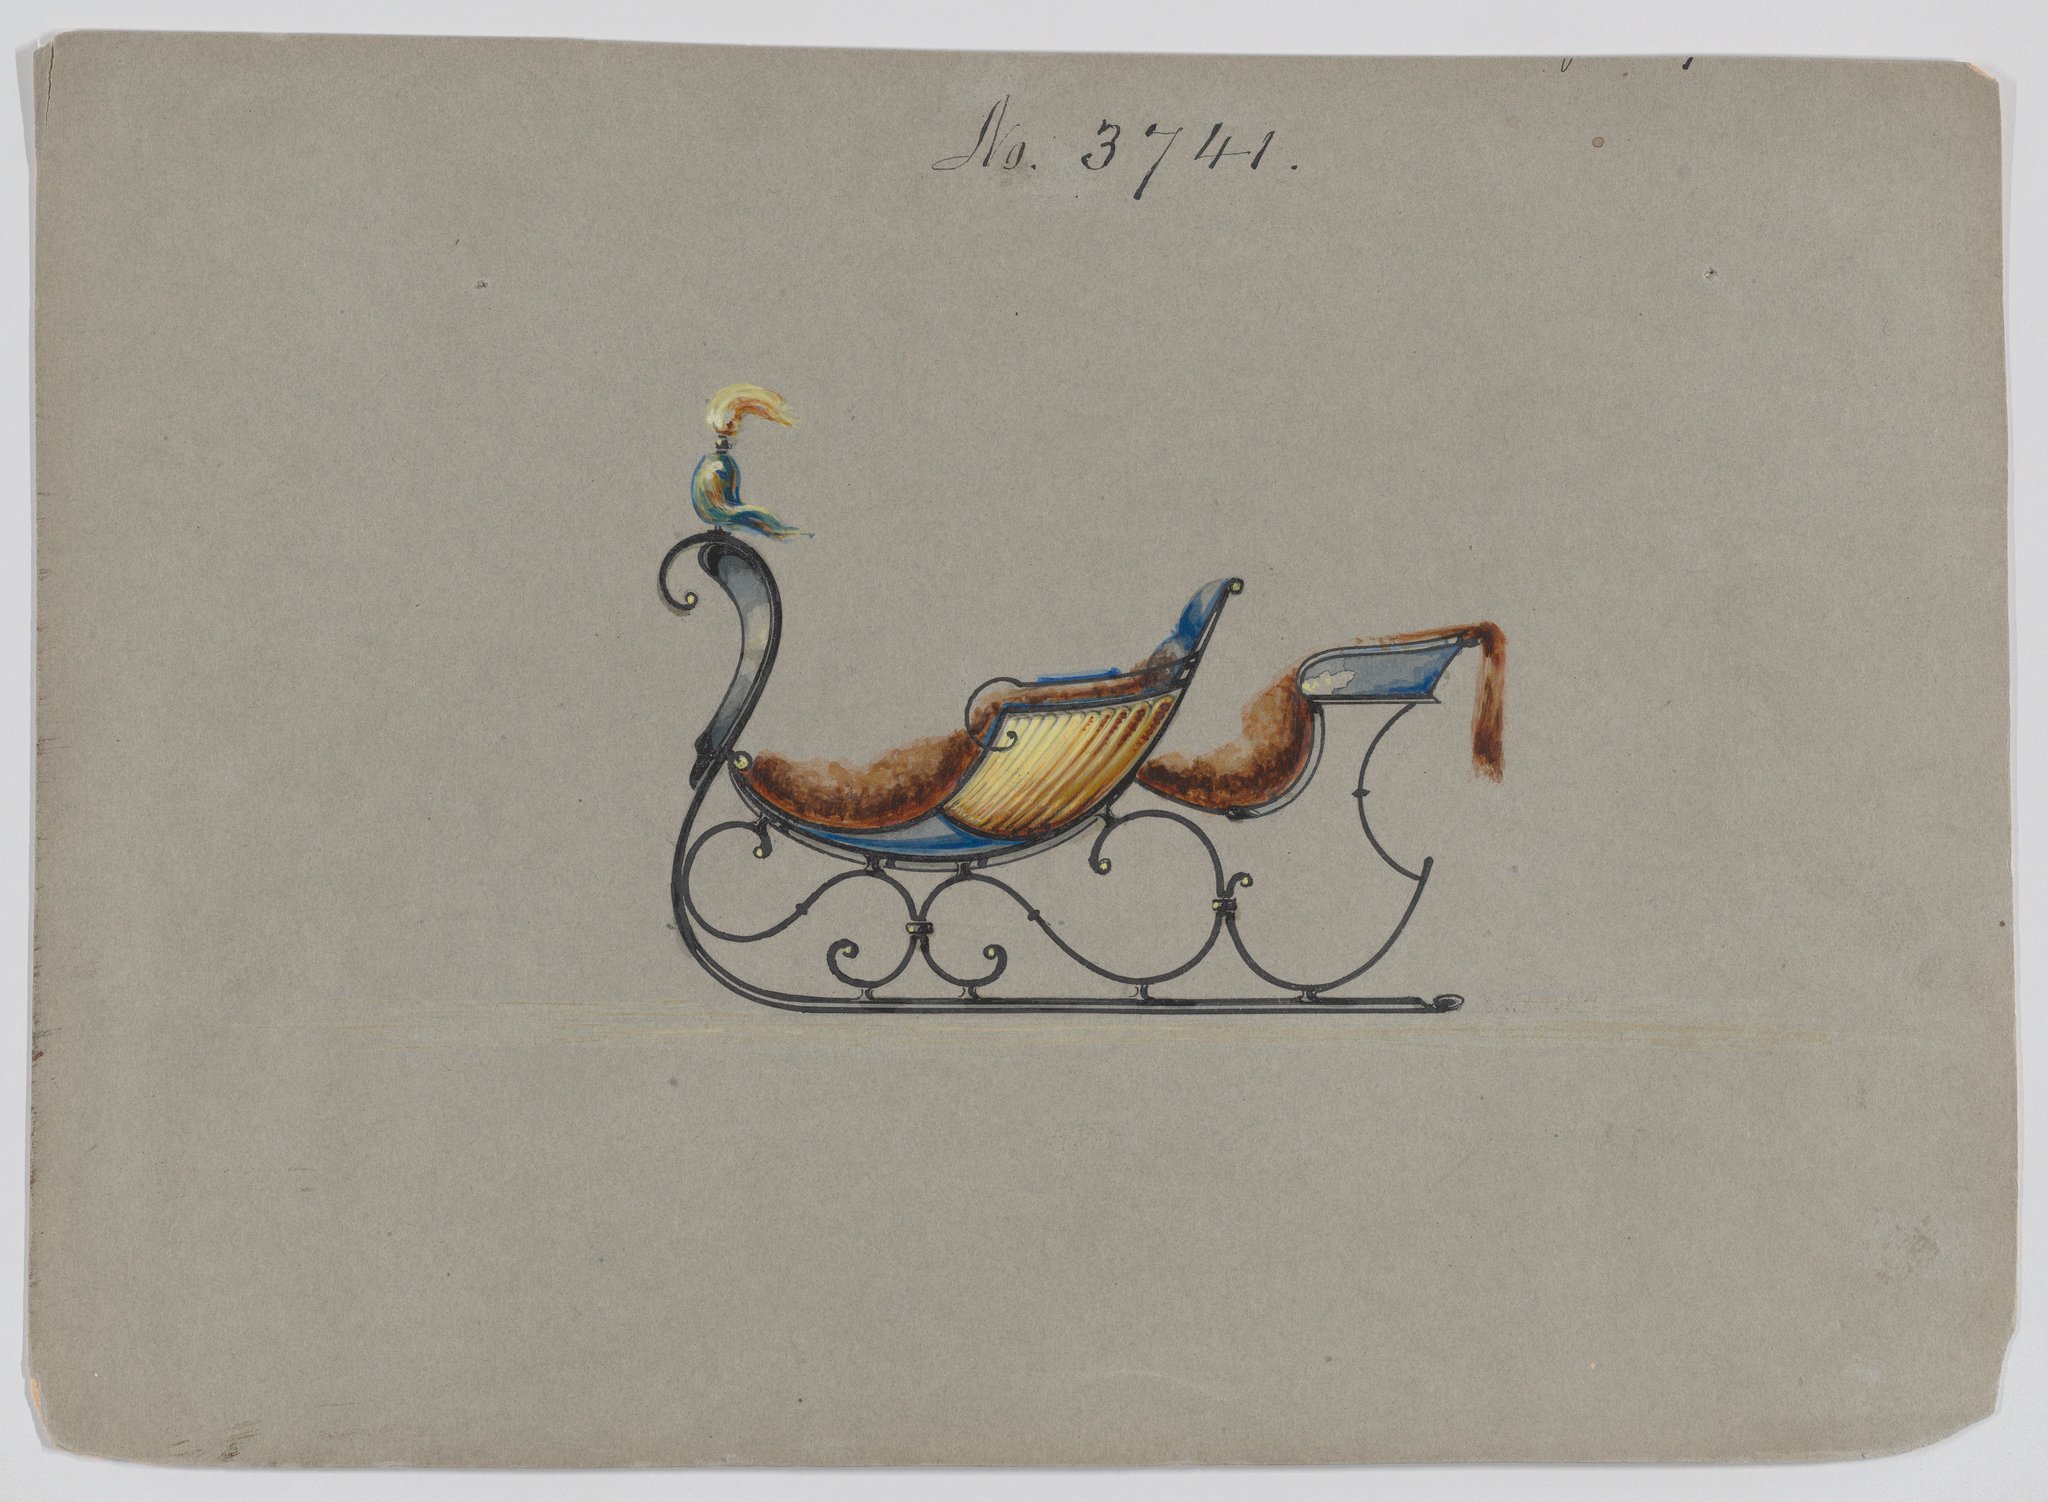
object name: drawing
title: Design for Rumble Sleigh, no. 3741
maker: brewster & co.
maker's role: manufacturer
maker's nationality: american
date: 1882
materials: gouache, gum arabic, ink, watercolor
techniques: pen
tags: sleighs